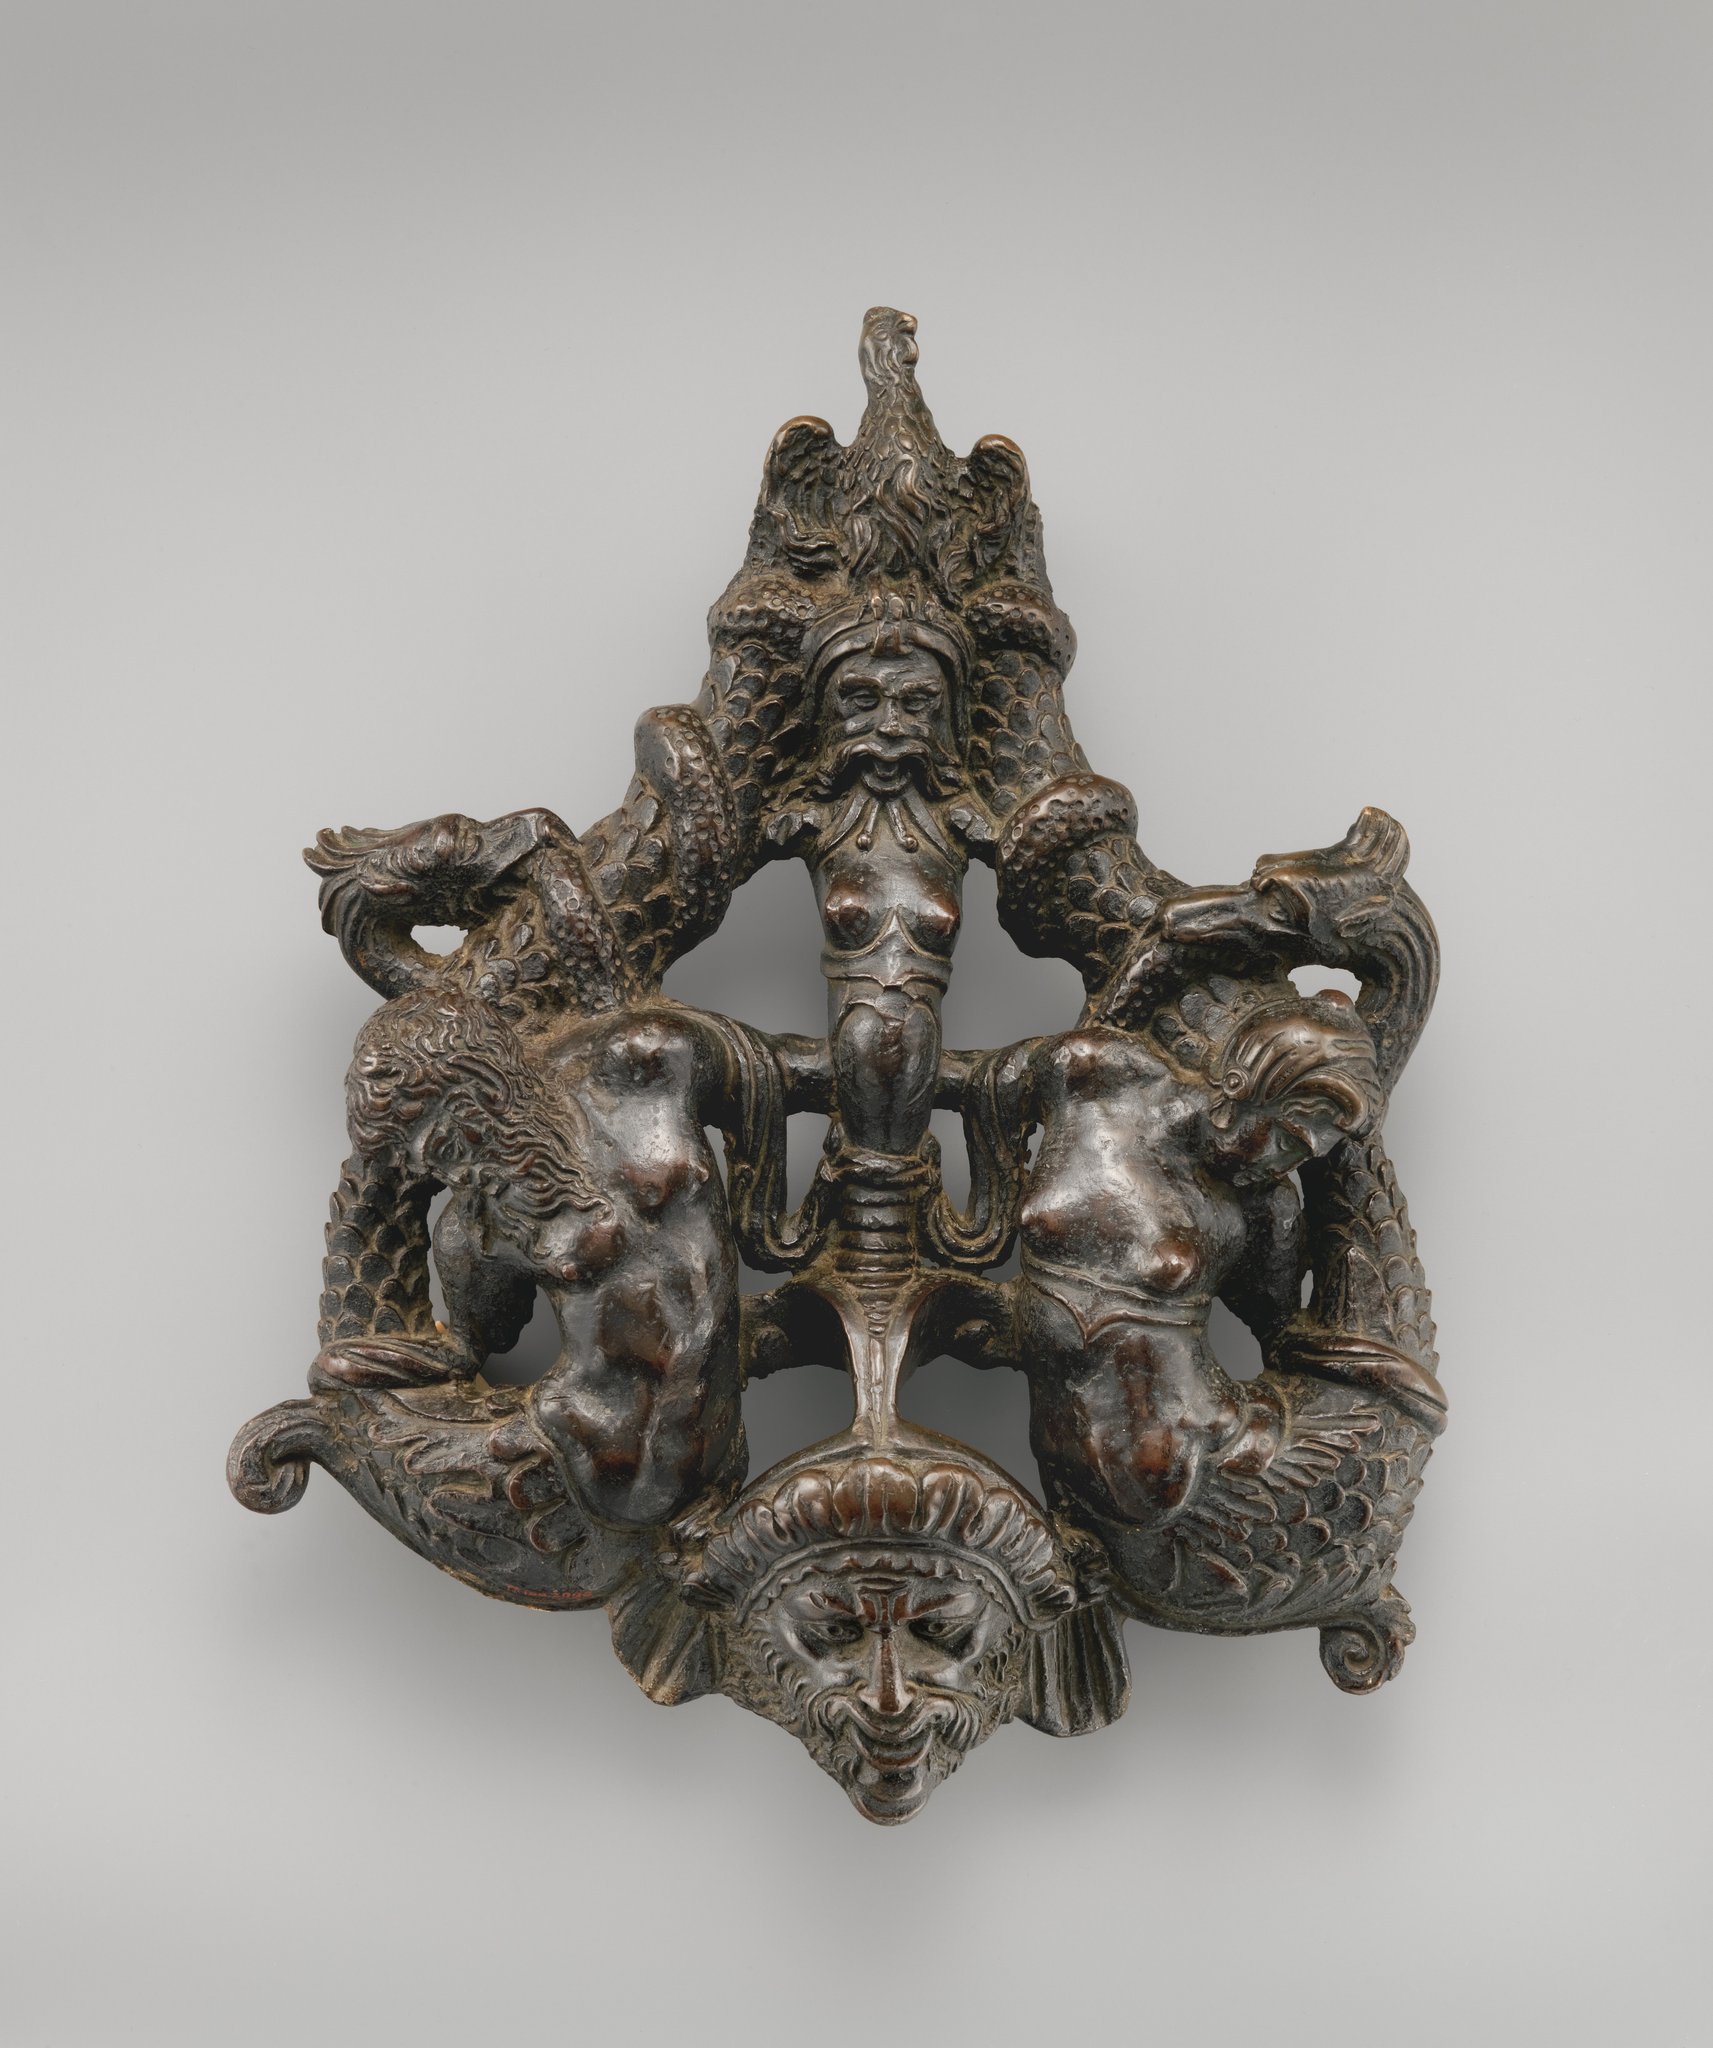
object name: door knocker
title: Doorknocker with a Triton and a Nereid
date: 1567-1600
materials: bronze, iron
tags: birds,faces,dragons,mermaids